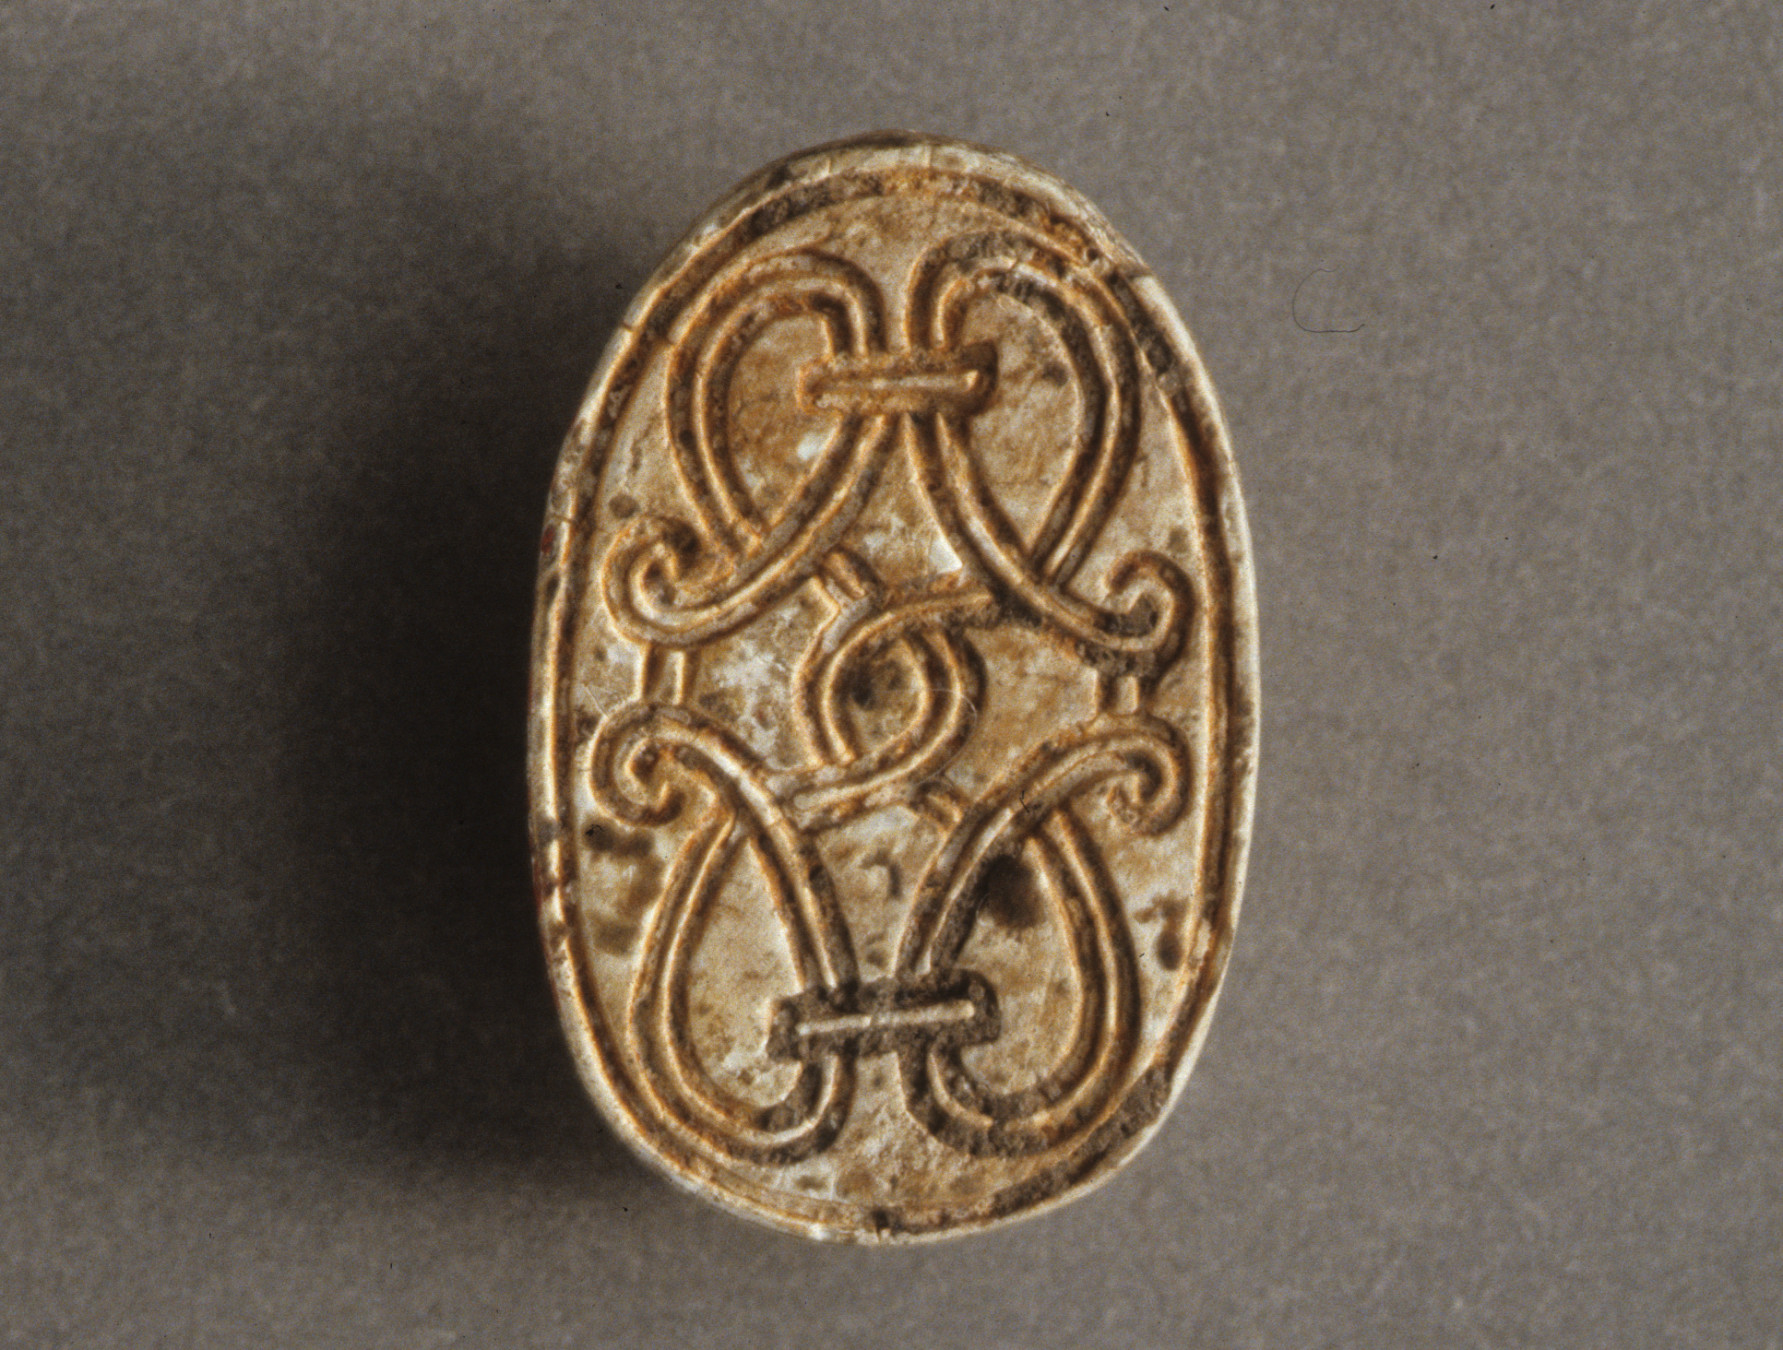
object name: scarab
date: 1648-1540 BCE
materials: stone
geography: eastern delta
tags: scarabs